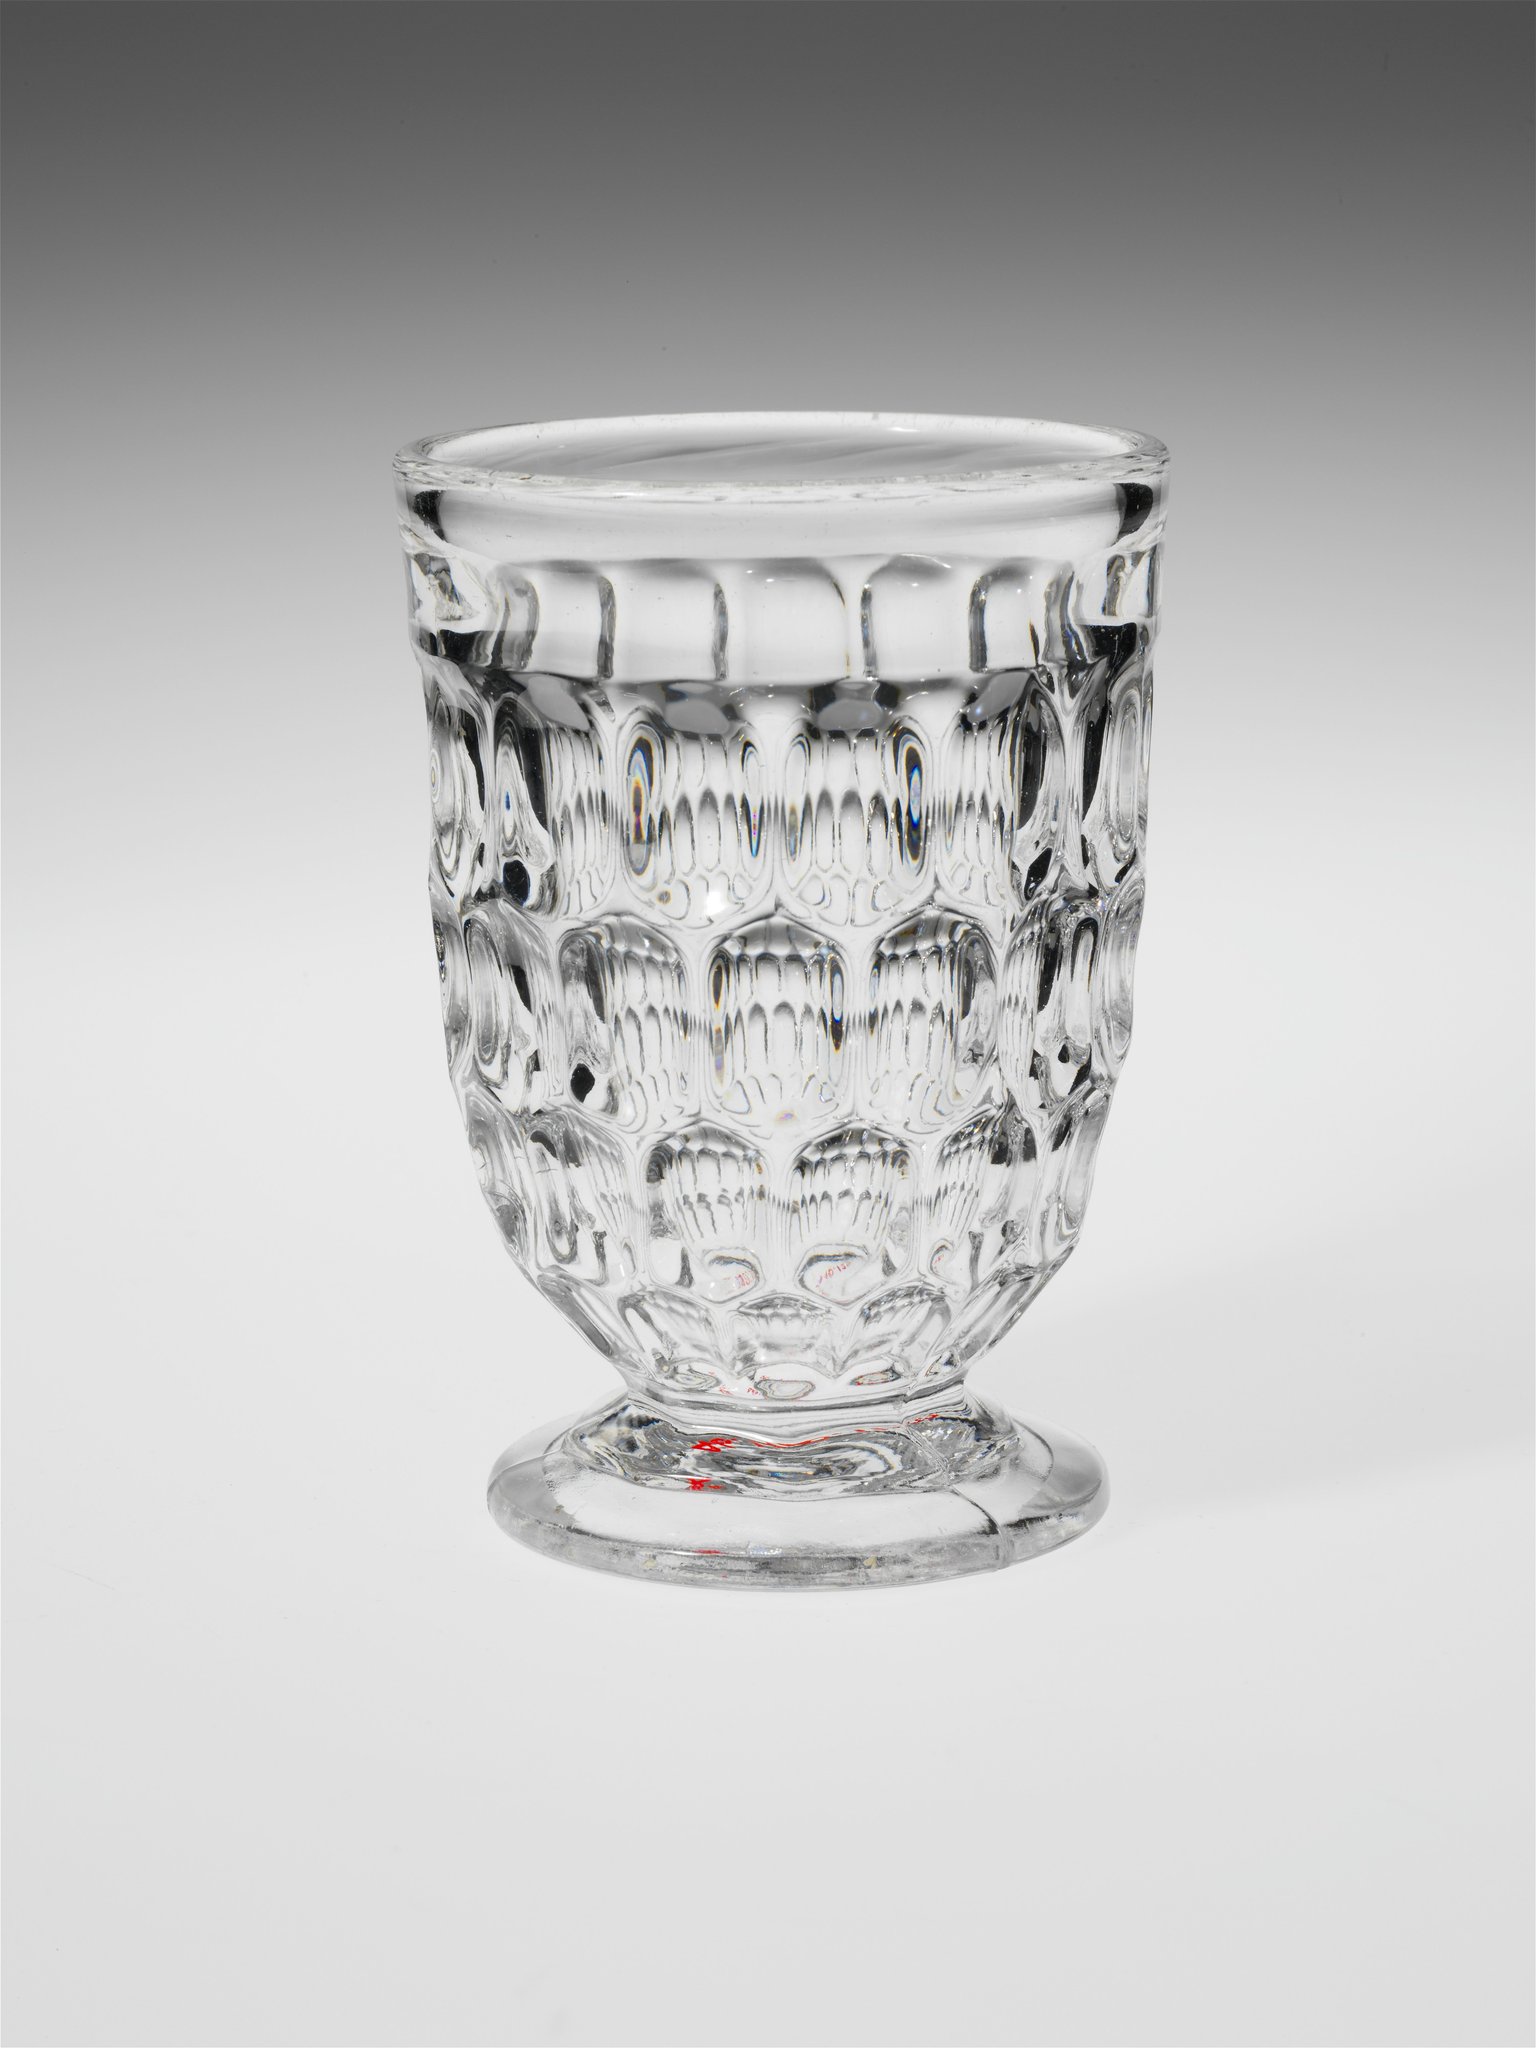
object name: tumbler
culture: american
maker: bakewell, pears and company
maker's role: maker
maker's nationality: american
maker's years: 1836-1882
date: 1850-1870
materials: glass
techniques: pressed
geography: united states